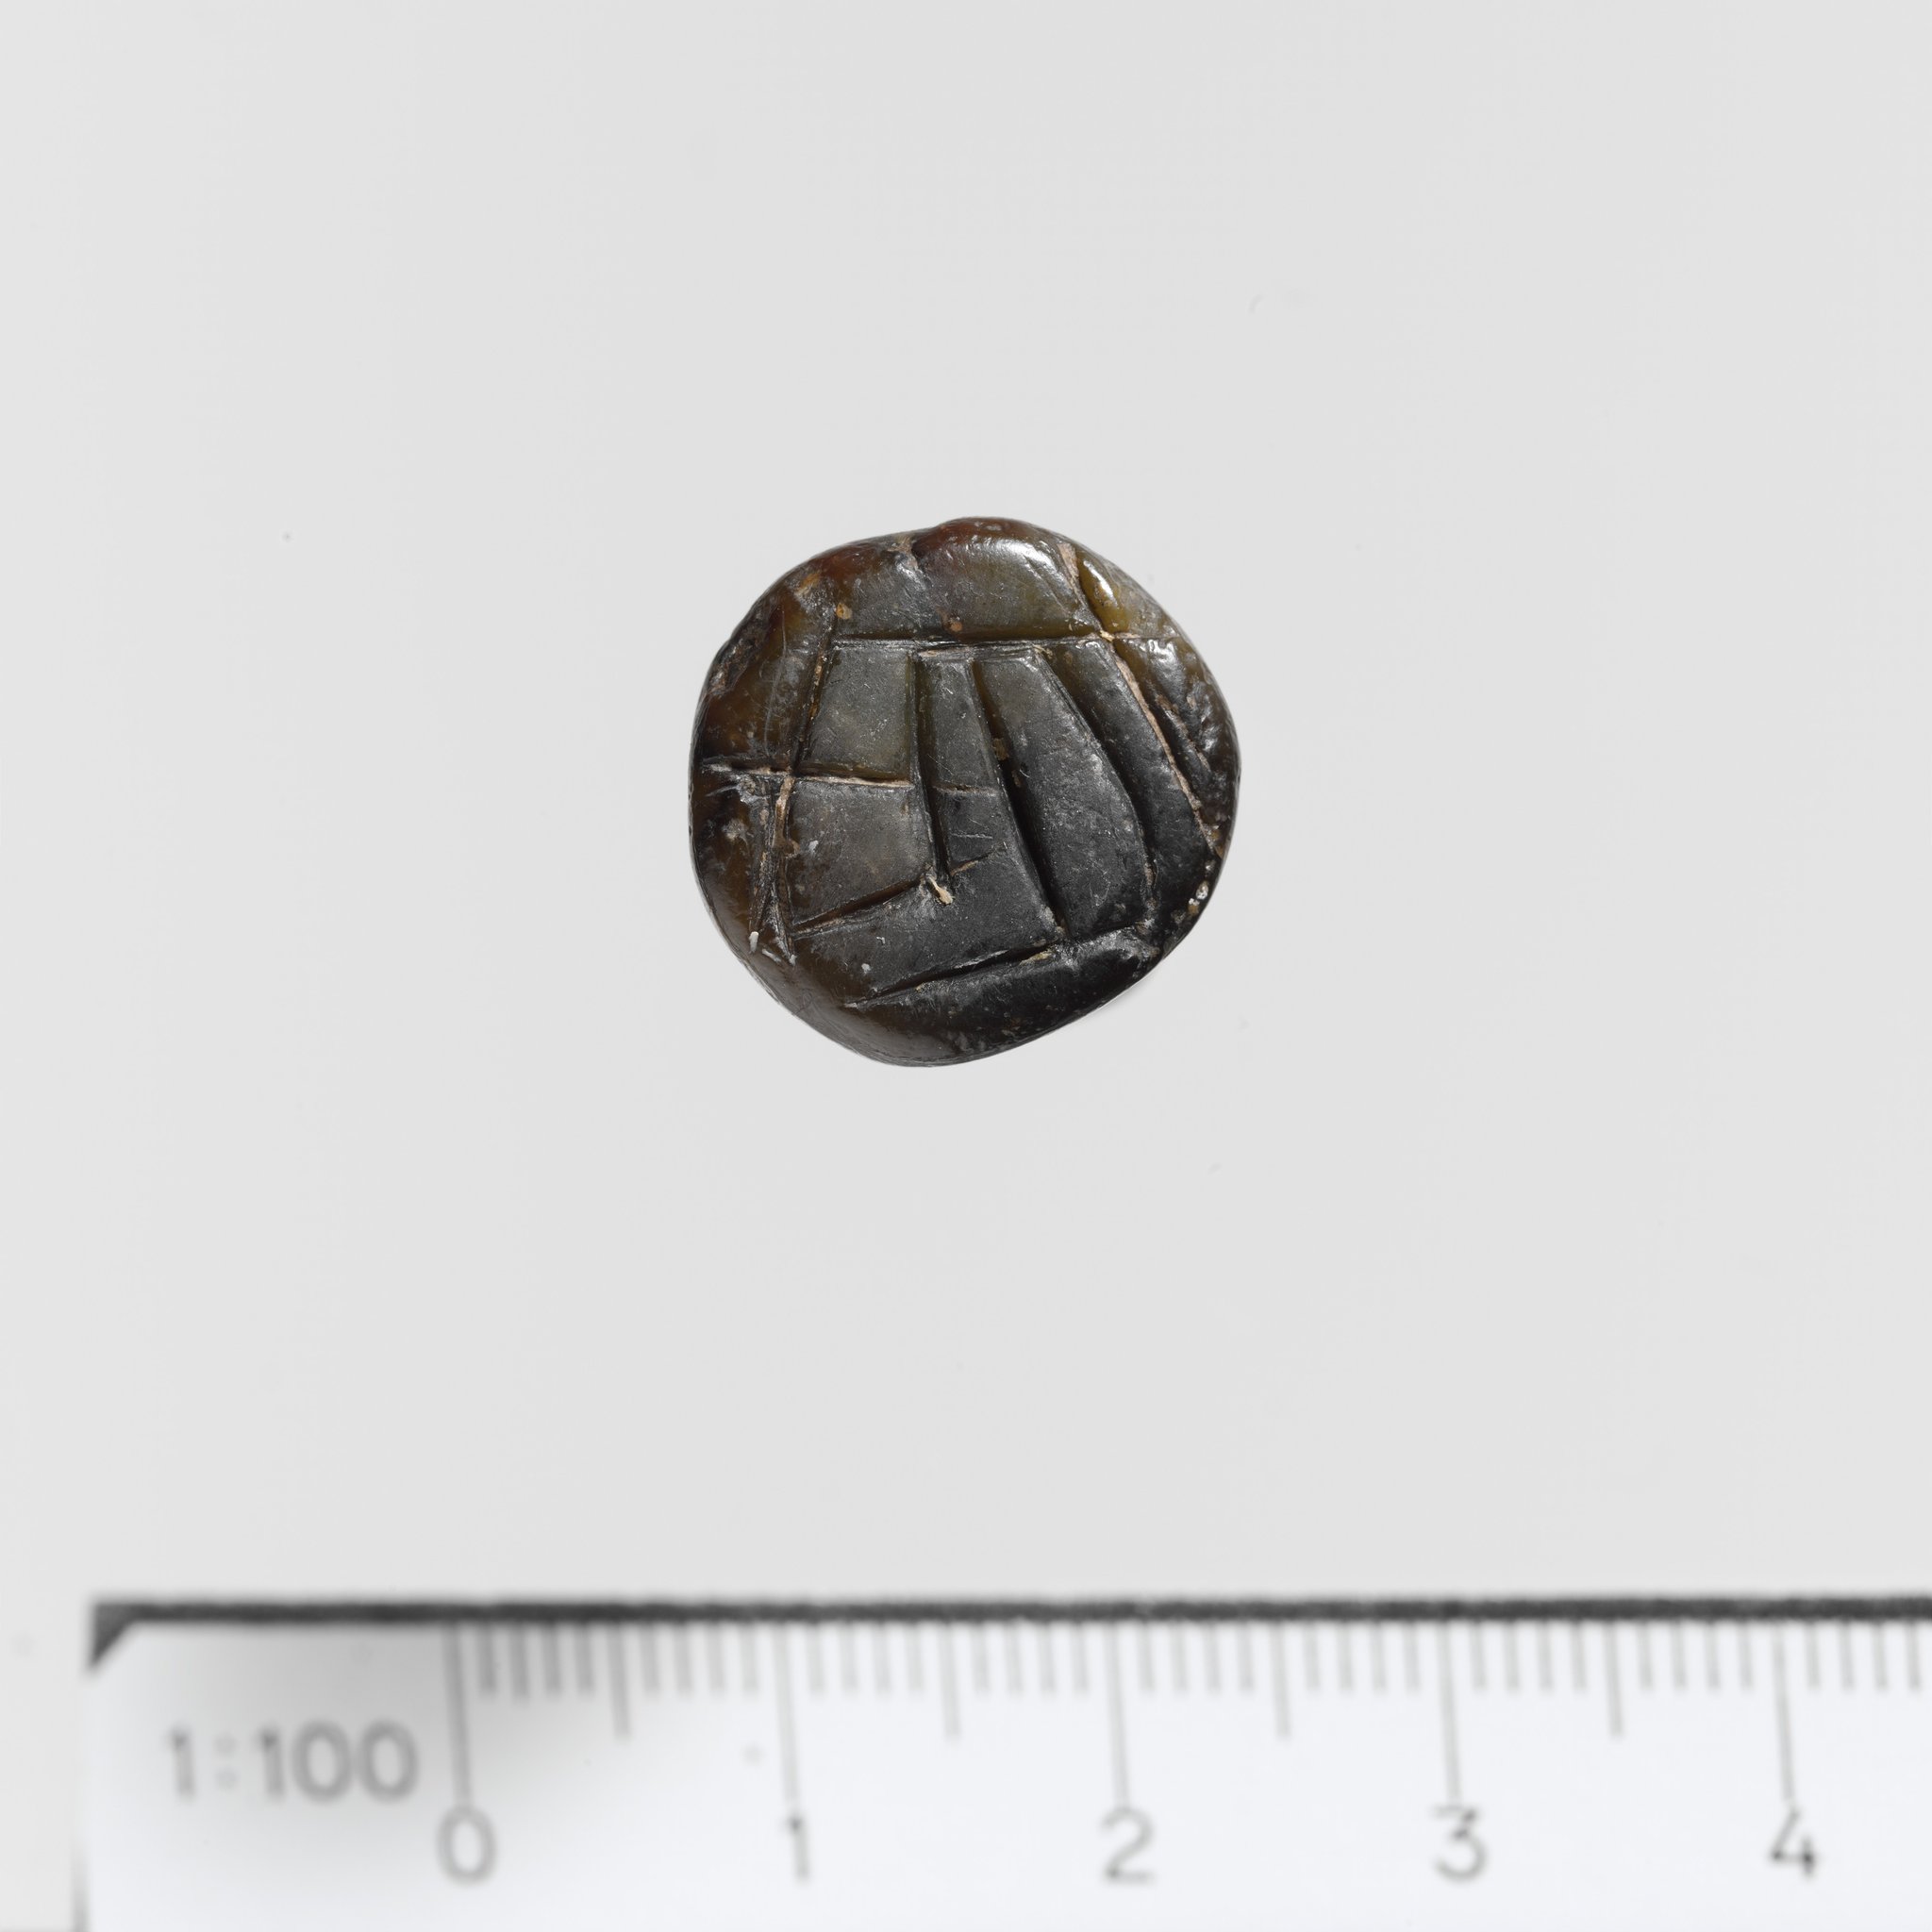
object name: seal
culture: minoan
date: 2600-2000 BCE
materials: stone